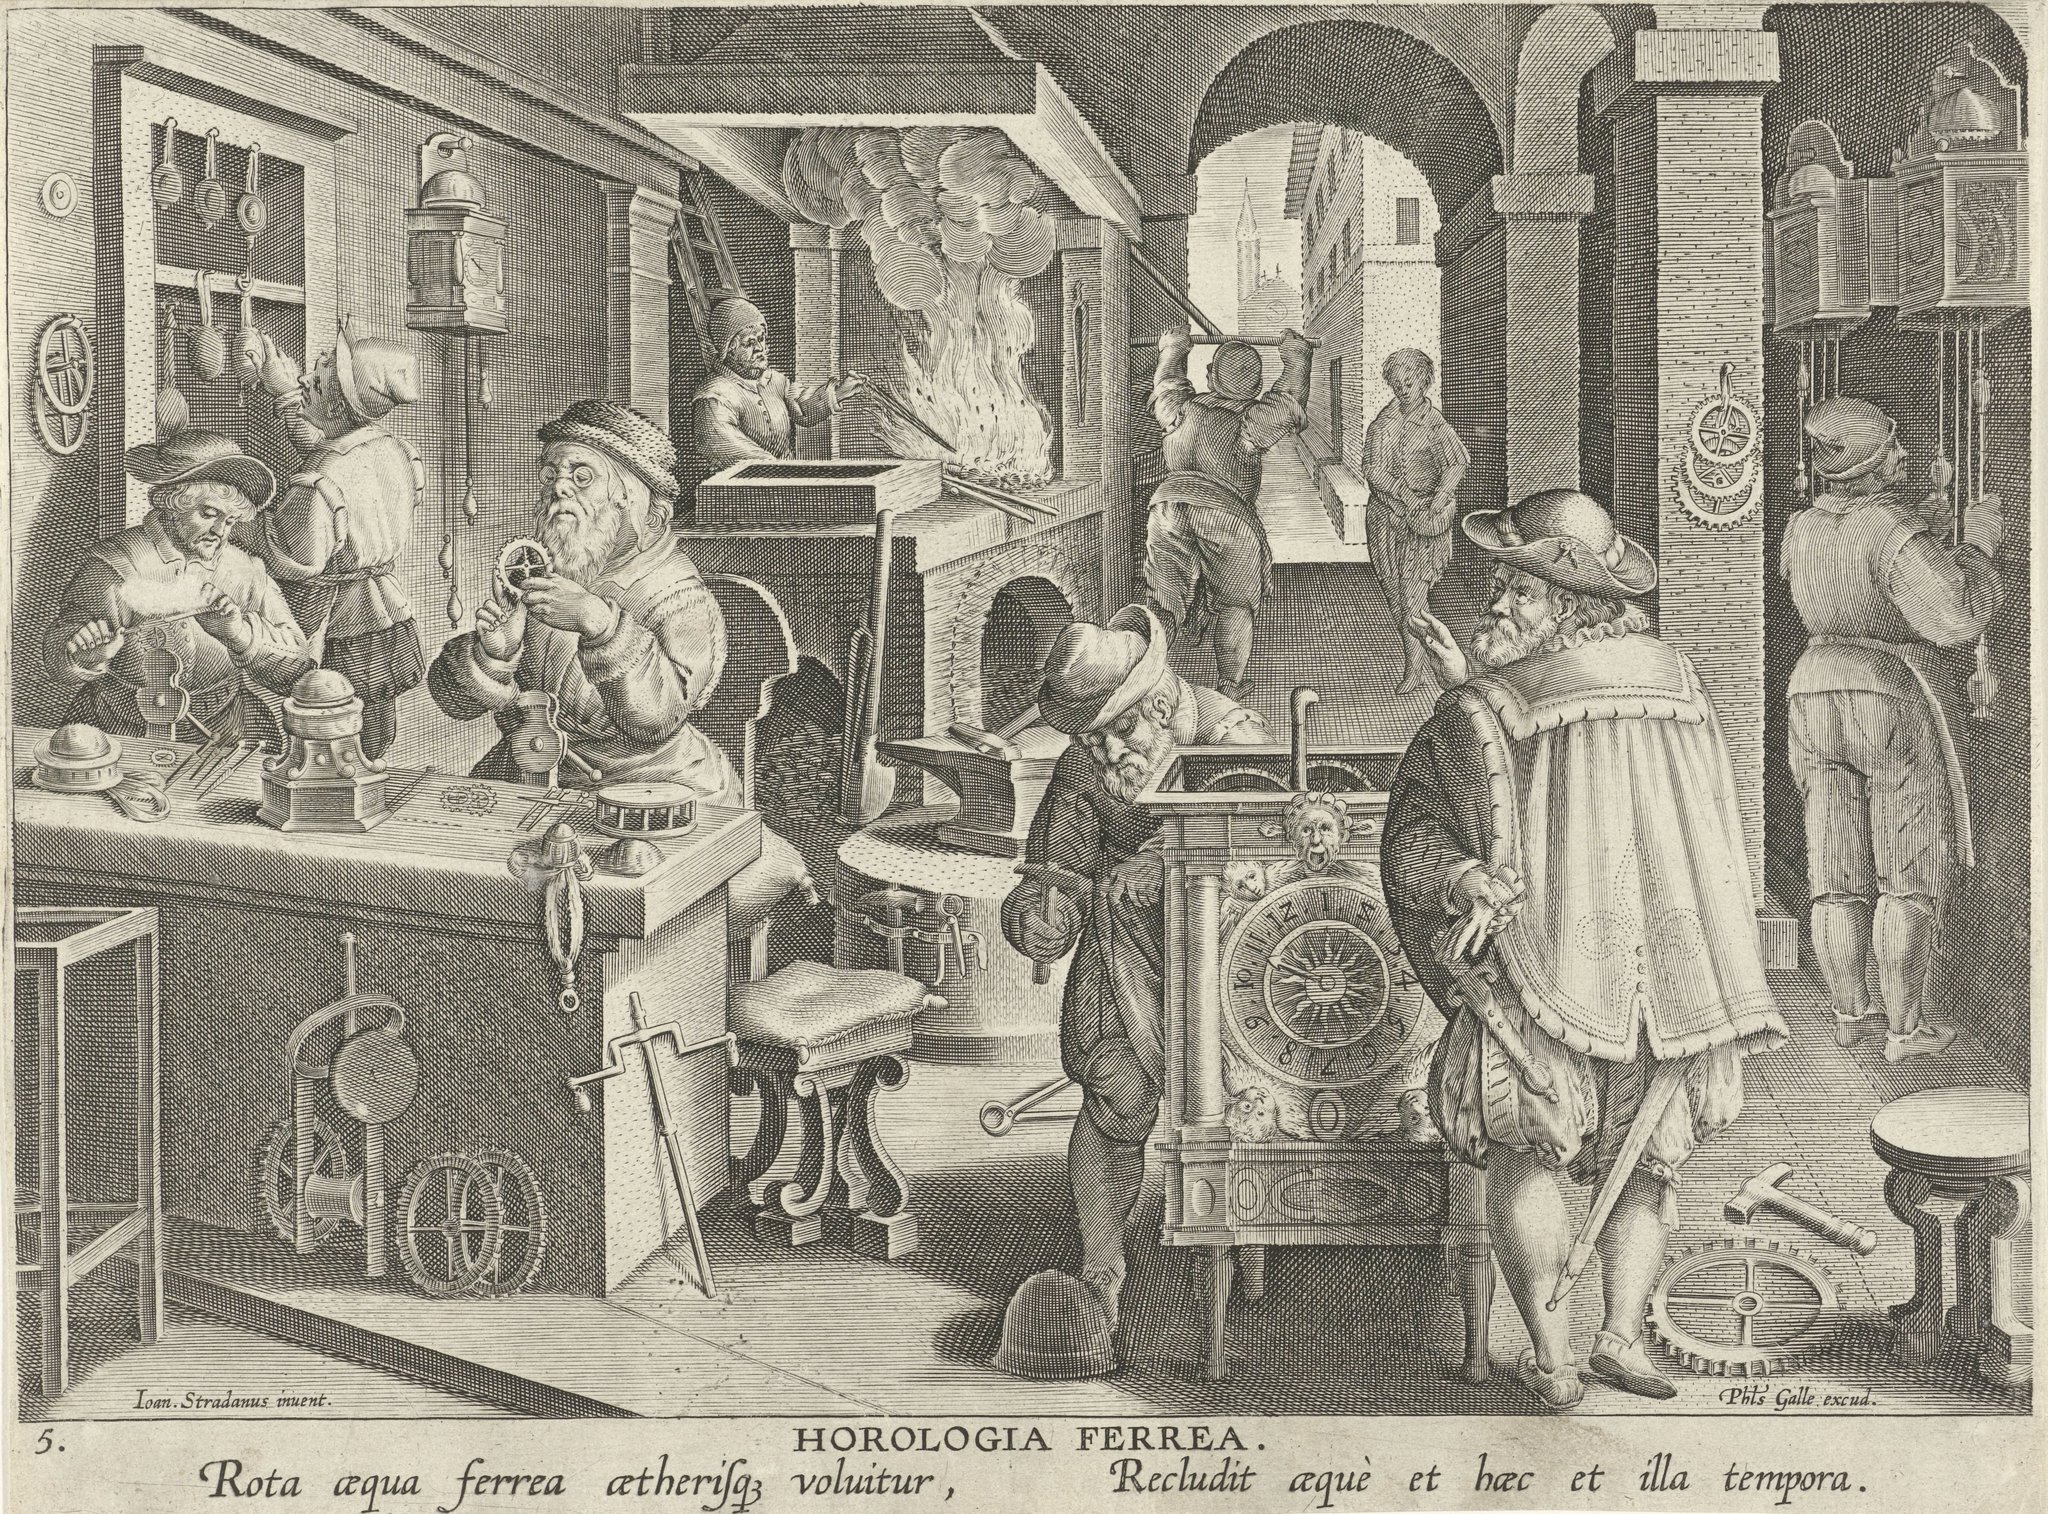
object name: print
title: Nieuwe uitvindingen en ontdekkingen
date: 1589-1593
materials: paper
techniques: engraving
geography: antwerp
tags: invention, discovery ~ science and technology, workshop (+ men (labourers)), watchmaker, clockmaker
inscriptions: collector's mark: Lugt 2228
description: Werkplaats waar uurwerken worden vervaardigd. Links twee klokkenmakers bezig aan een werkbank met het raderwerk. Middenvoor een klok met wijzerplaat. Op de achtergrond links wordt een oven gestookt; rechts hangen klokken aan de wand. De prent maakt deel uit van een negentiendelige serie over nieuwe uitvindingen en ontdekkingen.